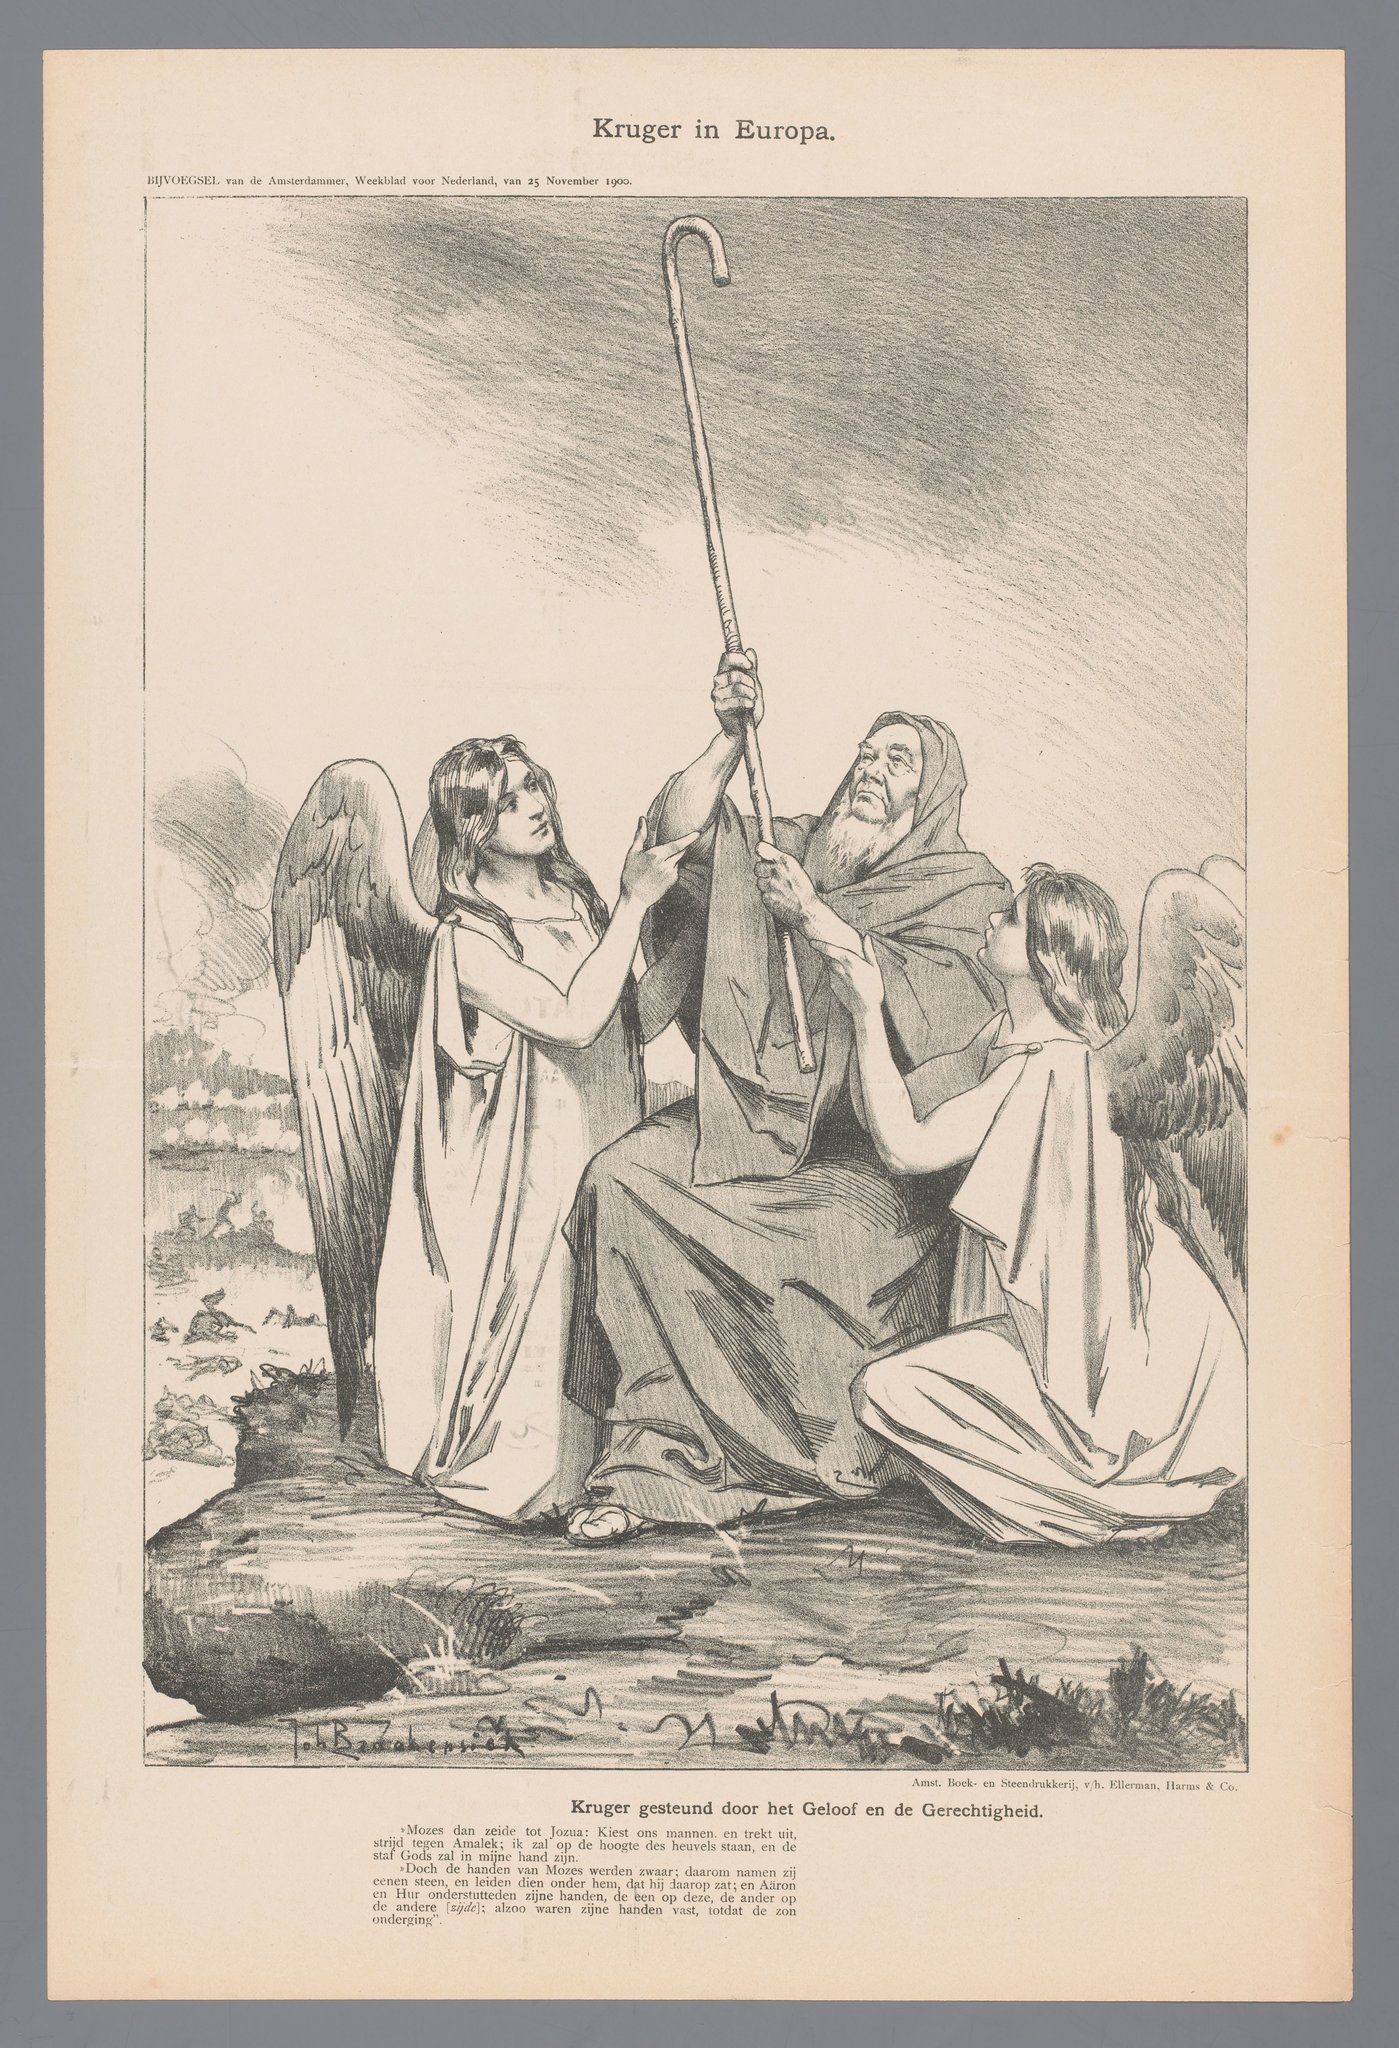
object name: cartoon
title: Kruger in Europa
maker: johan braakensiek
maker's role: draughtsman, print maker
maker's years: 1858-1940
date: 1900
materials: paper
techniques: lithograph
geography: amsterdam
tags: moses sitting on a rock, arms held up by aaron and hur; the amalekites are defeated, historical persons, political caricatures and satires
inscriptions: date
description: Prent uit het bijvoegsel van: De Amsterdammer. Weekblad voor Nederland, 25 november 1900.